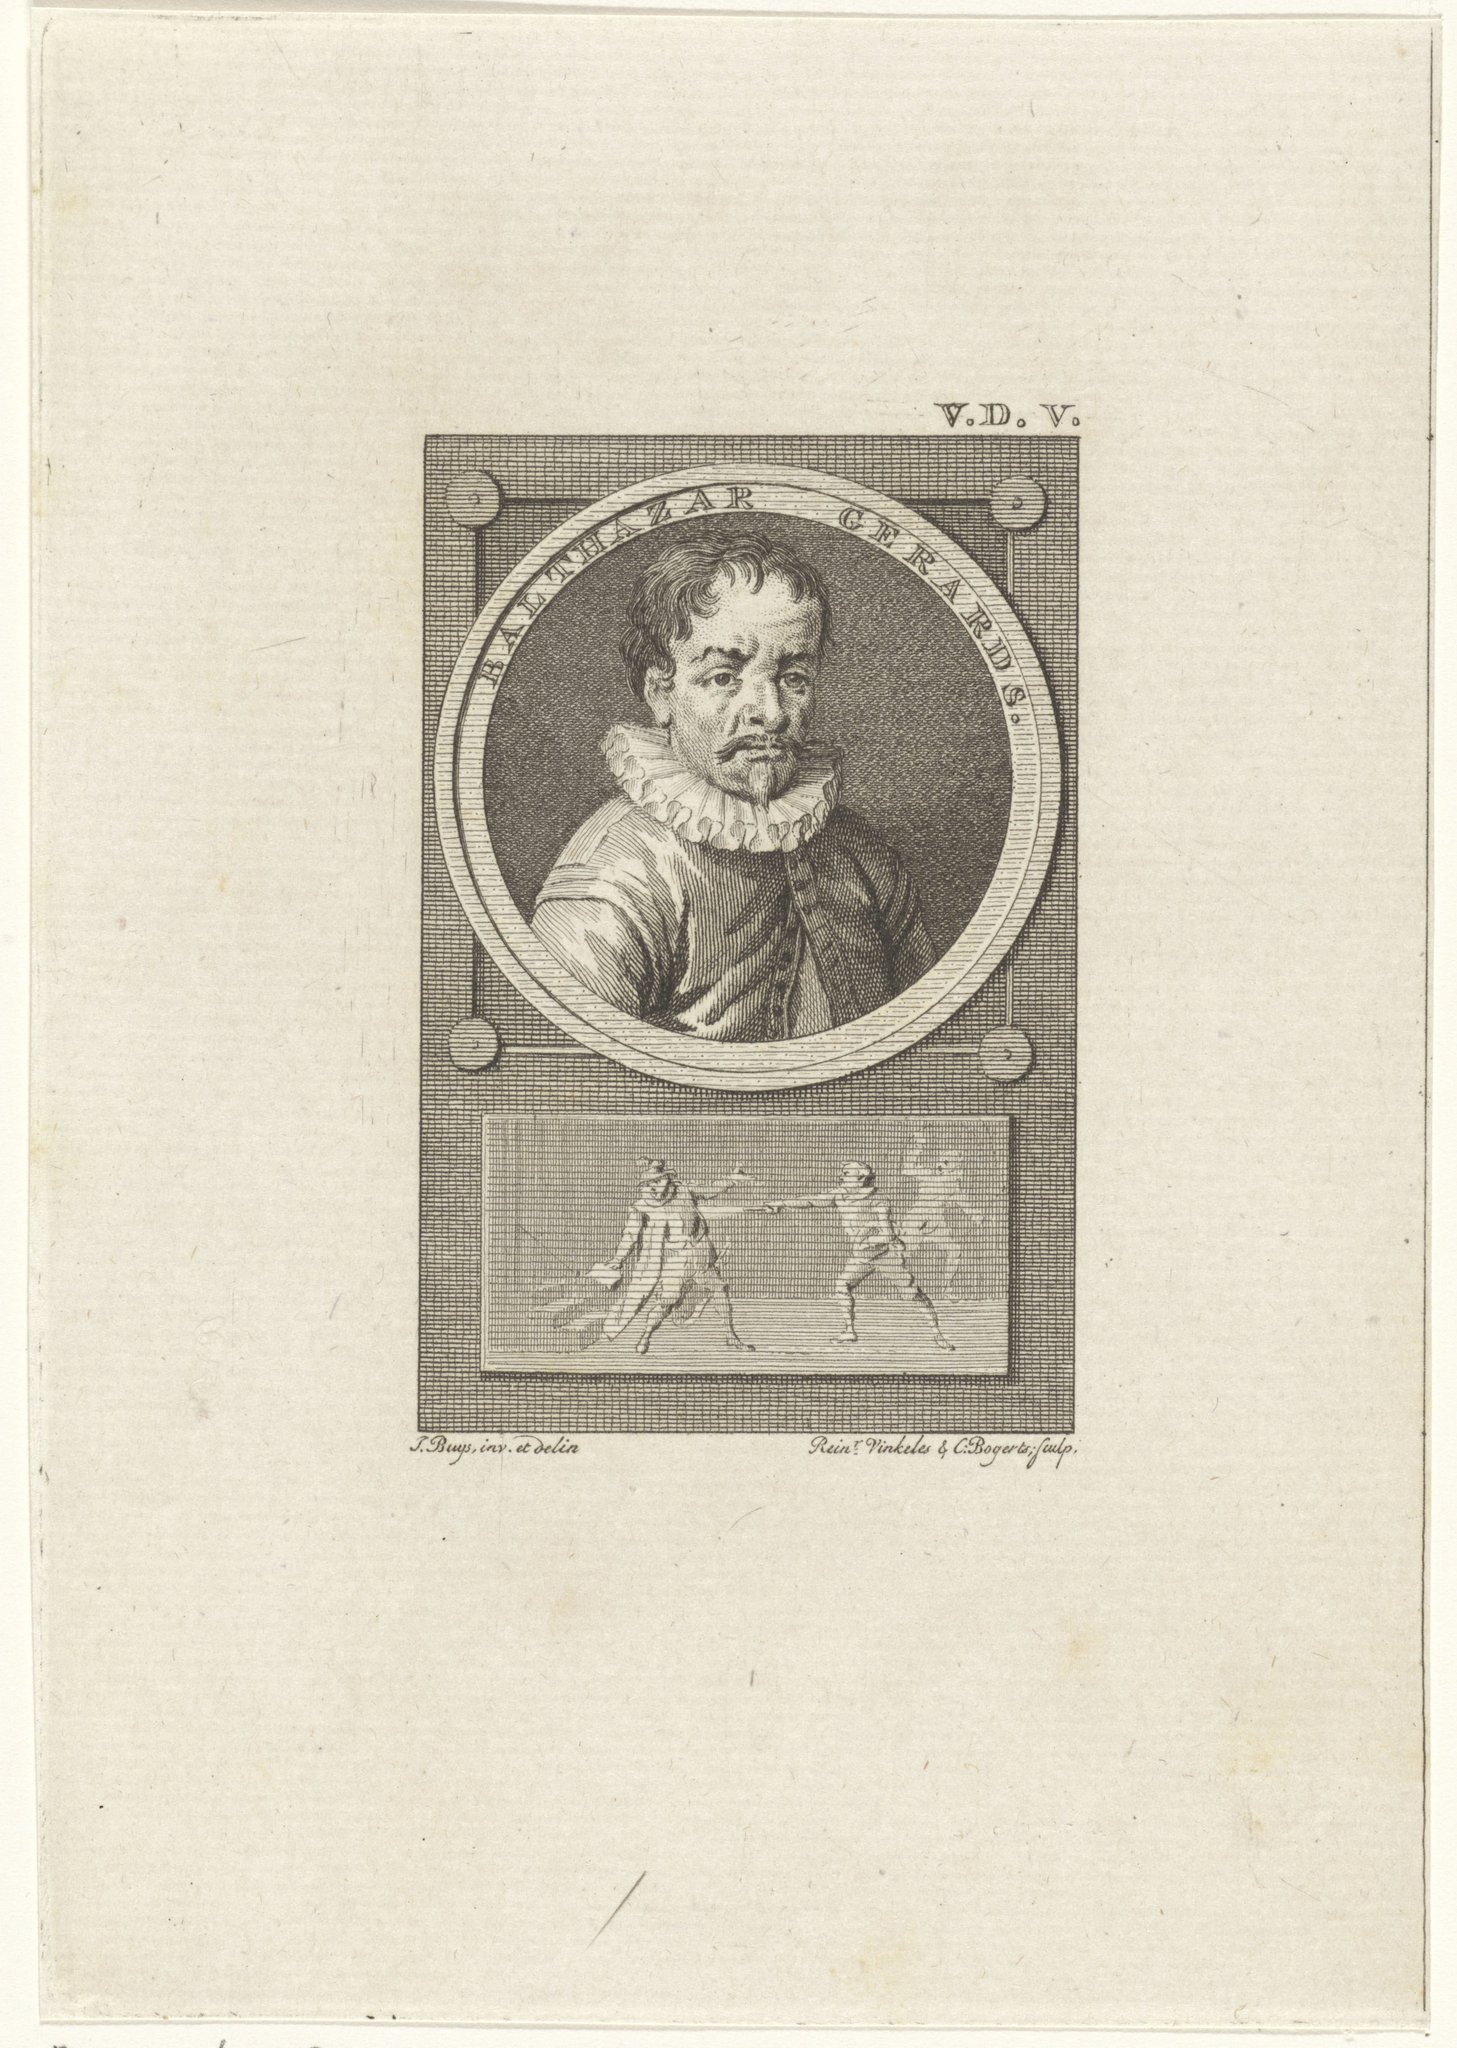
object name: print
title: Portret van Balthasar Gerards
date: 1783-1795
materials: paper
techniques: etching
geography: amsterdam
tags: delft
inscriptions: collector's mark: Lugt 2228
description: Prent gebruikt in: Fokke, Jan. Geschiedenissen der Vereenigde Nederlanden voor de vaderlandsche jeugd Ie-XXVste deel. Amsterdam: Johannes Allart, 1783-1795. Deel V.